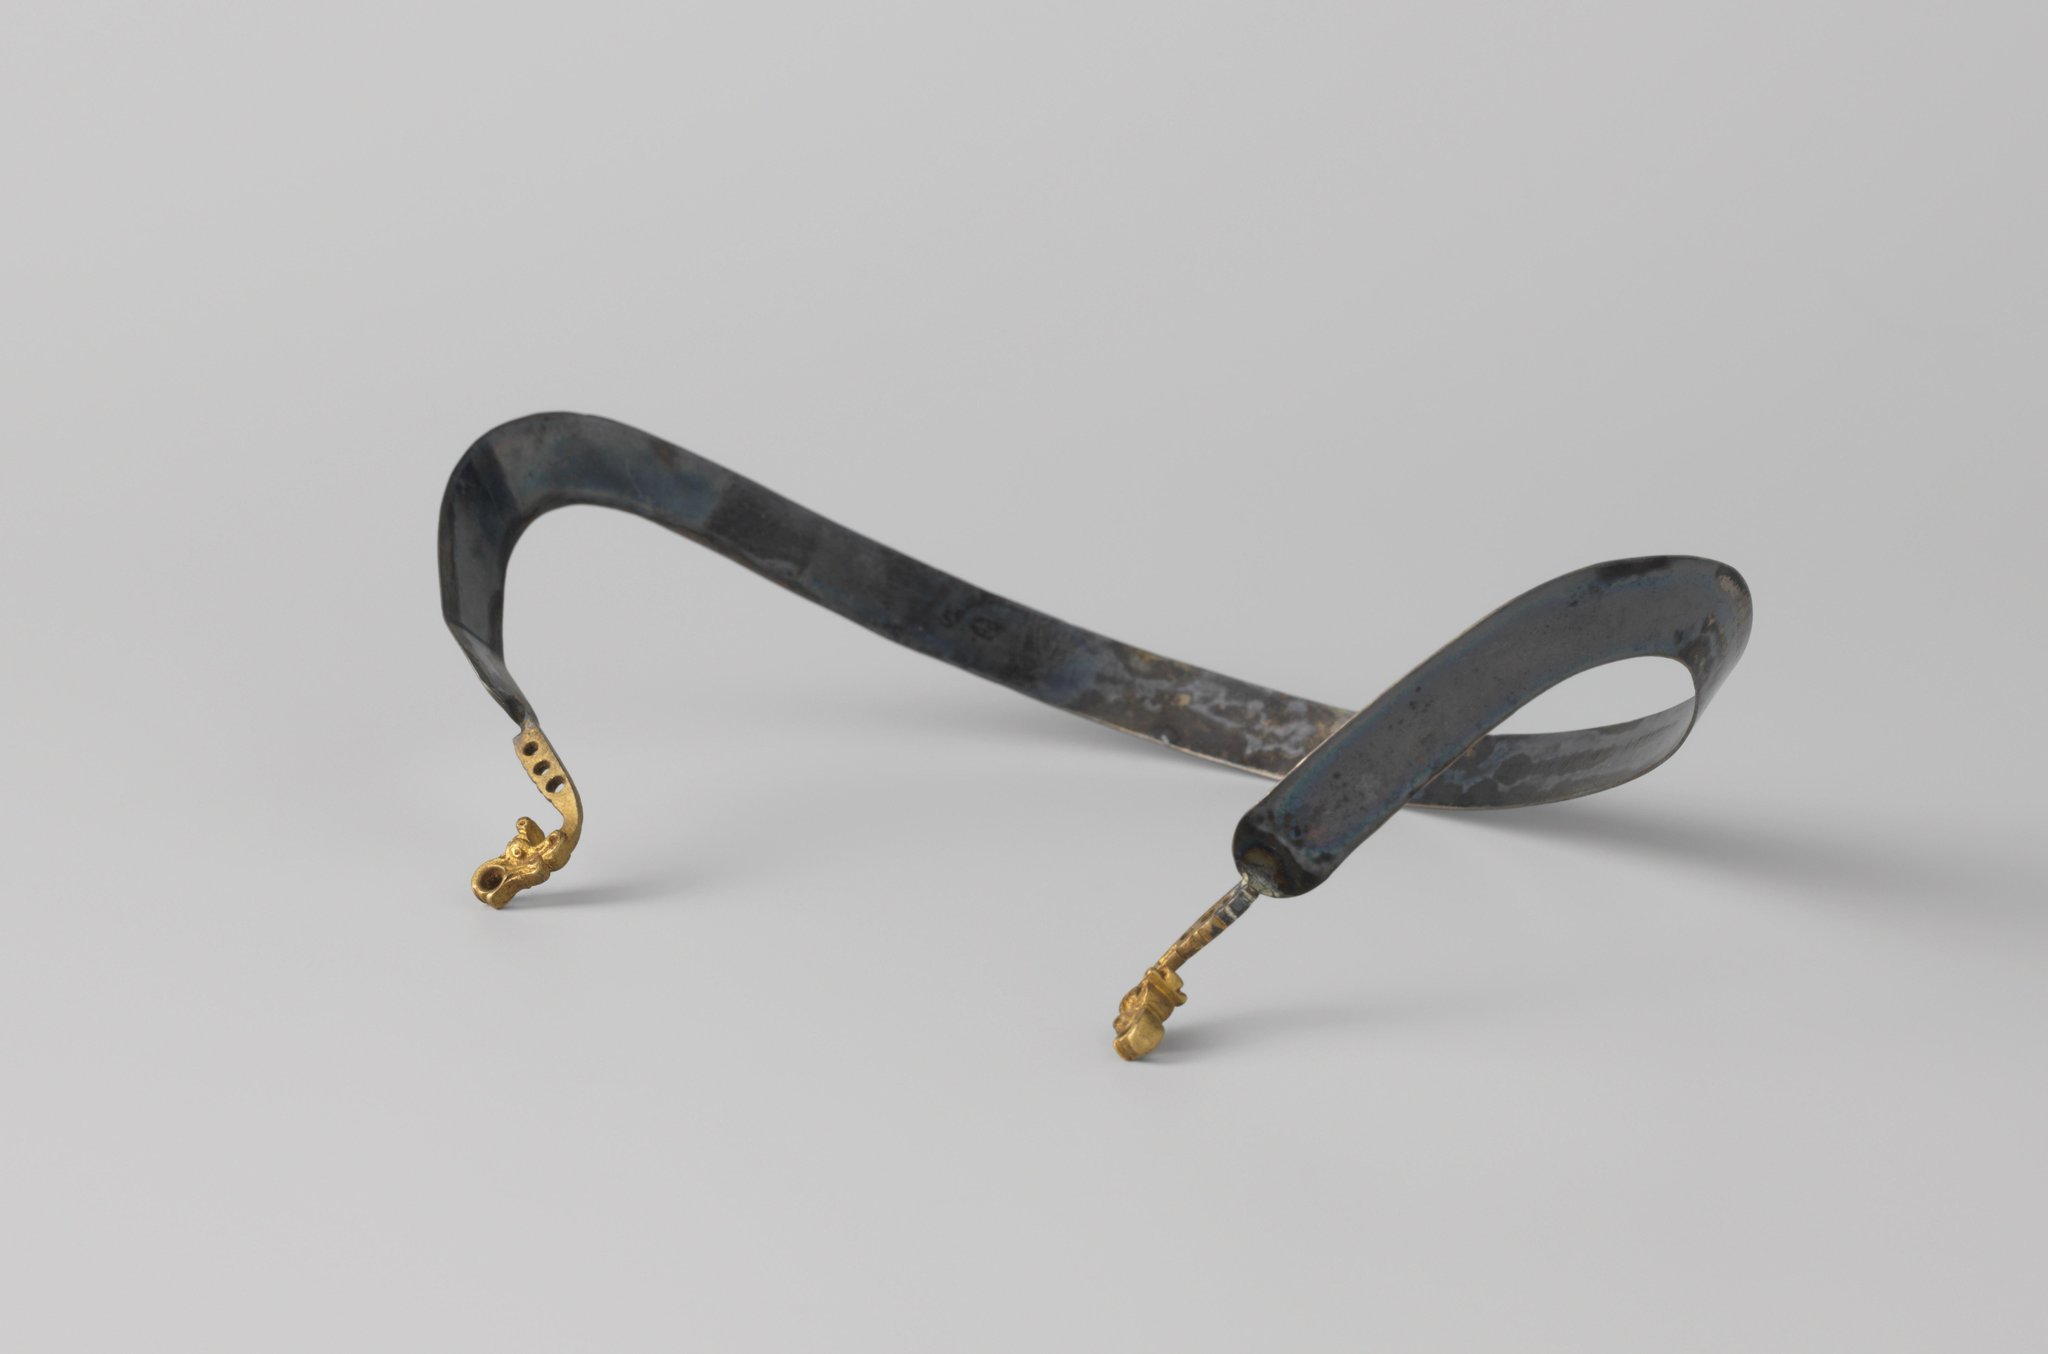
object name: jewellery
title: Oorijzer bestaande uit een platte band van zilver met gouden knoppen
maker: Anonymous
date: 1600-1699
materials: gold, silver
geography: dordrecht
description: Oorijzer bestaande uit een platte band van zilver met gouden knoppen.